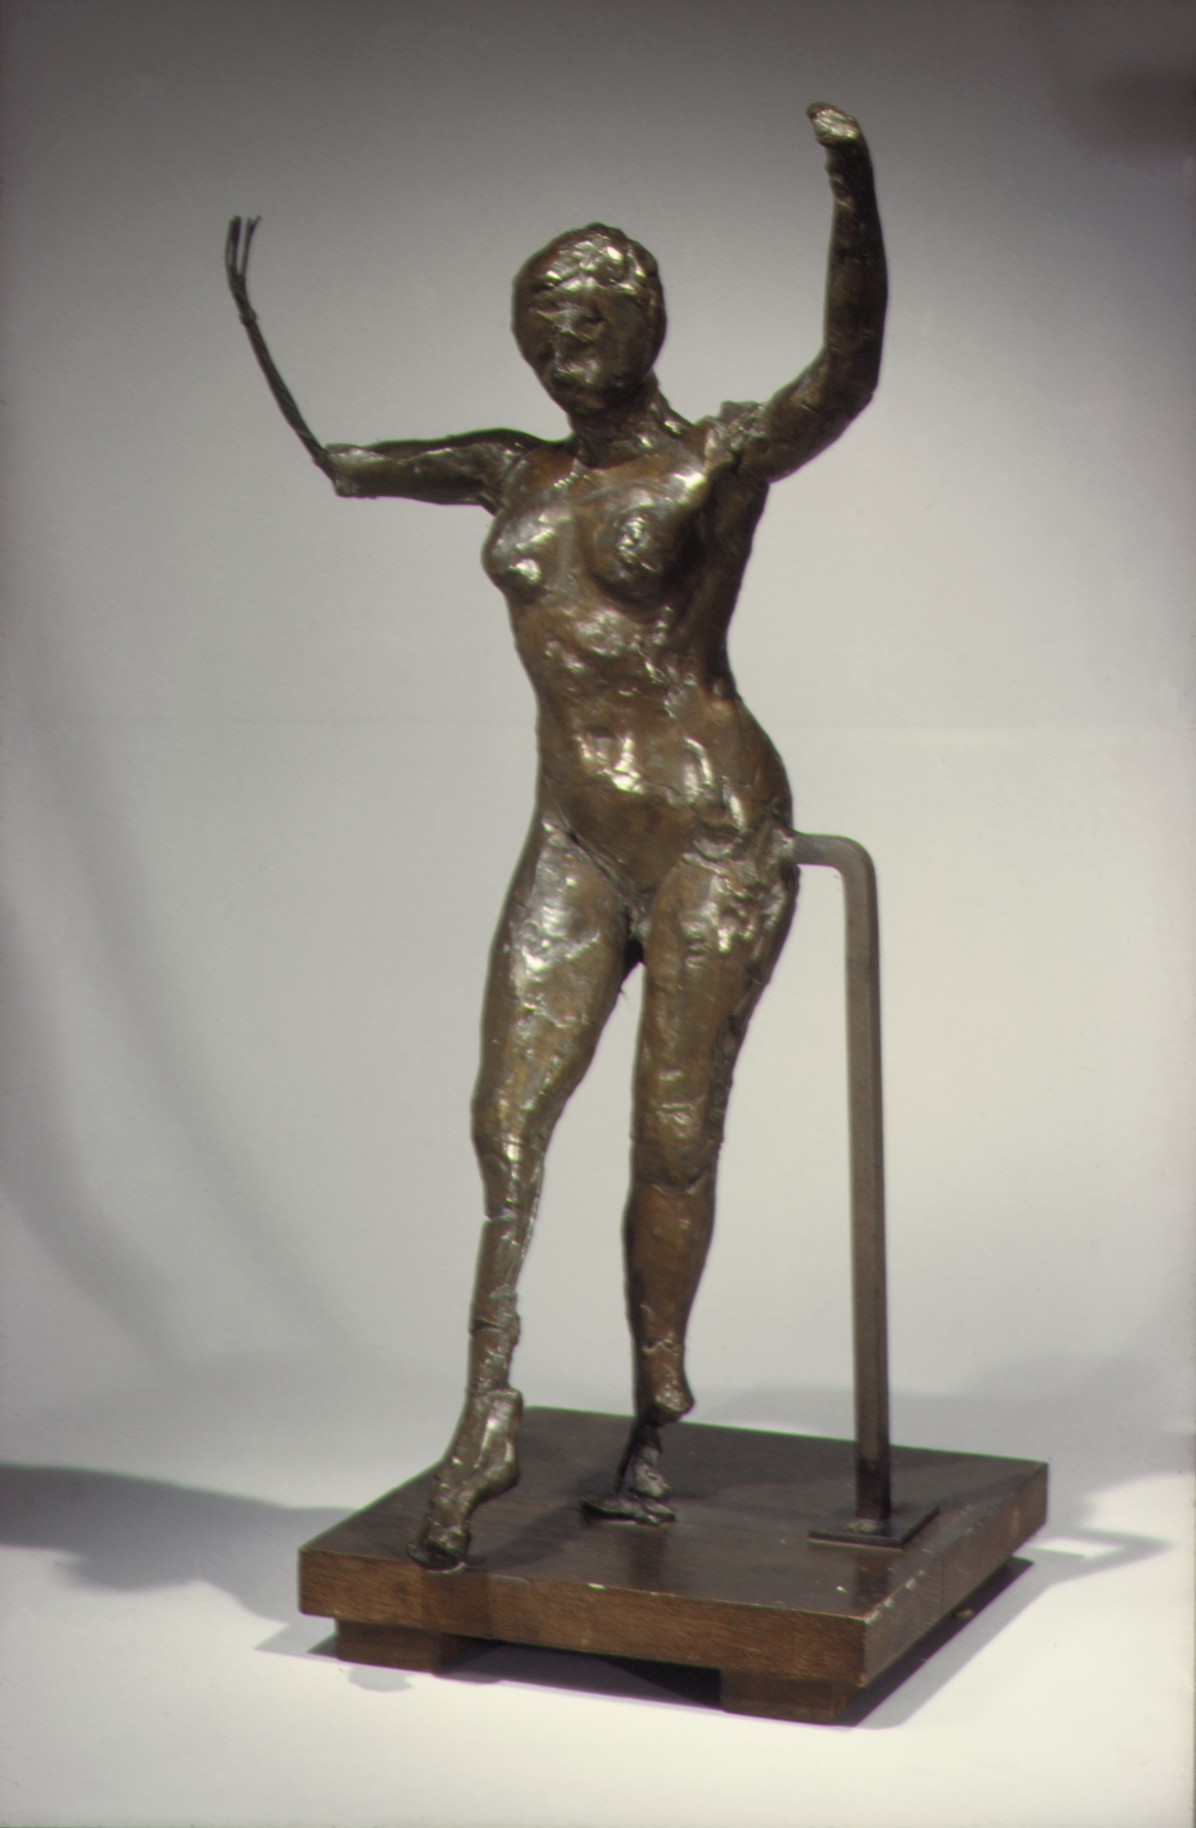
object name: statue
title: Dancer Moving Forward, Arms Raised, Right Leg Forward (Second State)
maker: edgar degas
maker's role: artist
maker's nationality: french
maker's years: 1834-1917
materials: bronze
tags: female nudes,dancing,dancers